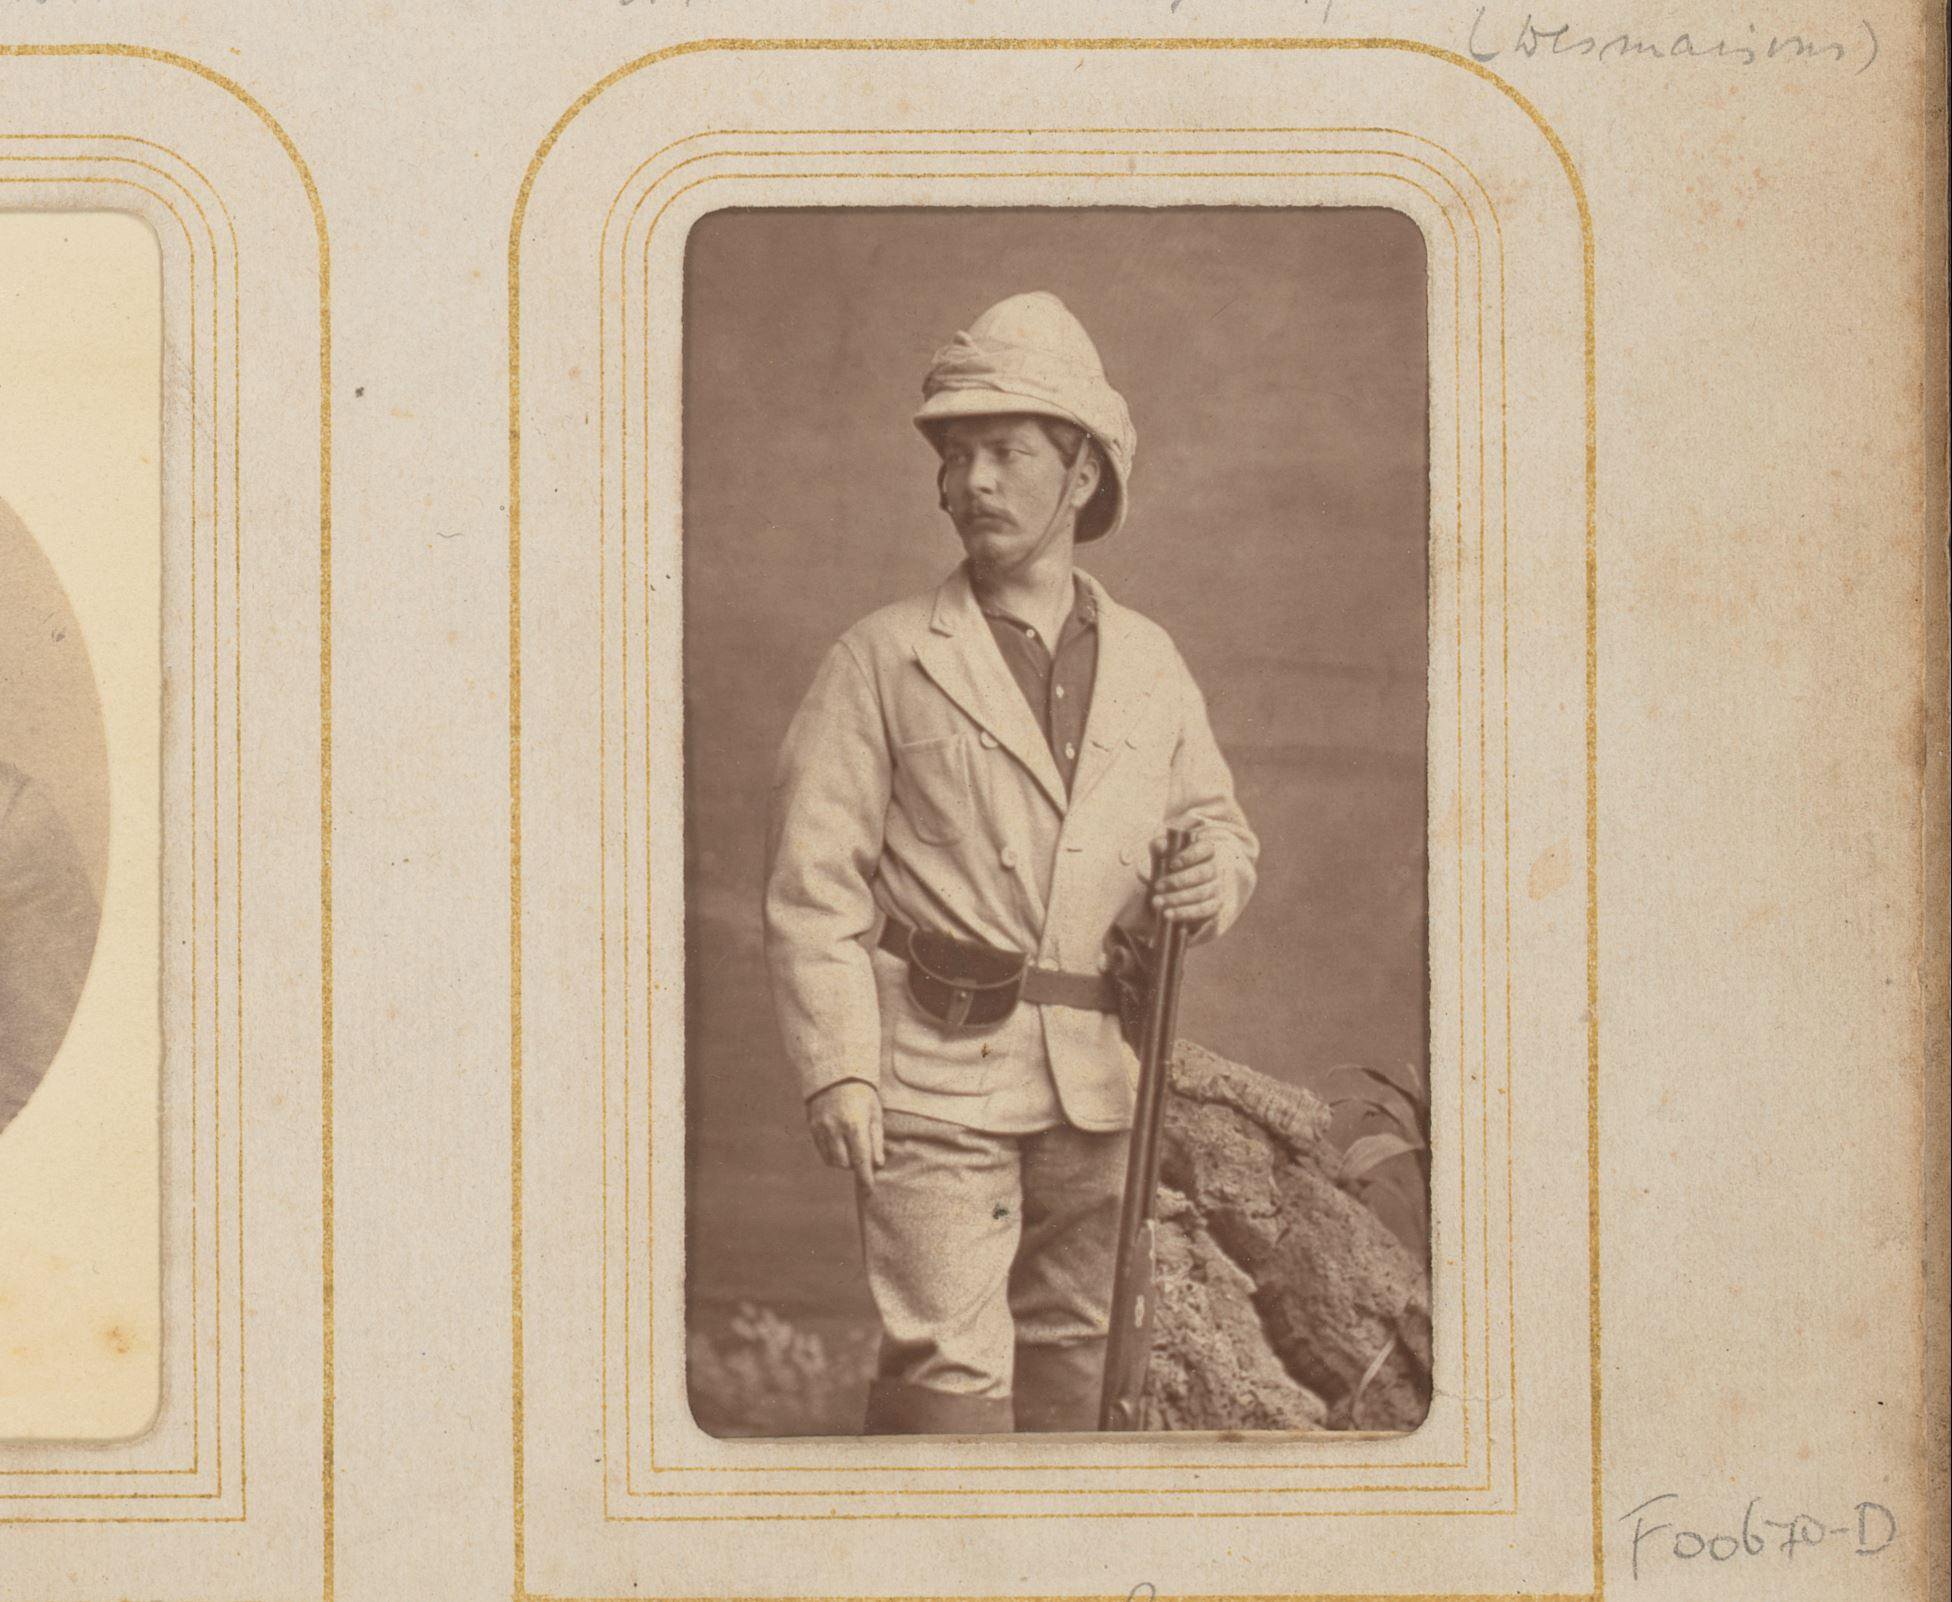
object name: photograph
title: Portret van Henry Morton Stanley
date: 1870-1885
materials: cardboard, photographic support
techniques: albumen print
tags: london, historical persons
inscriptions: inscription: ‘E. Moses & Son, London, Minories a. Aldgate, New Oxford St., Tottenham Court Rd.. Bradford. Yorkshire’, annotation: ‘Henri Morton Stanley/ Eng. Afrikareiziger 1841 - 1904’